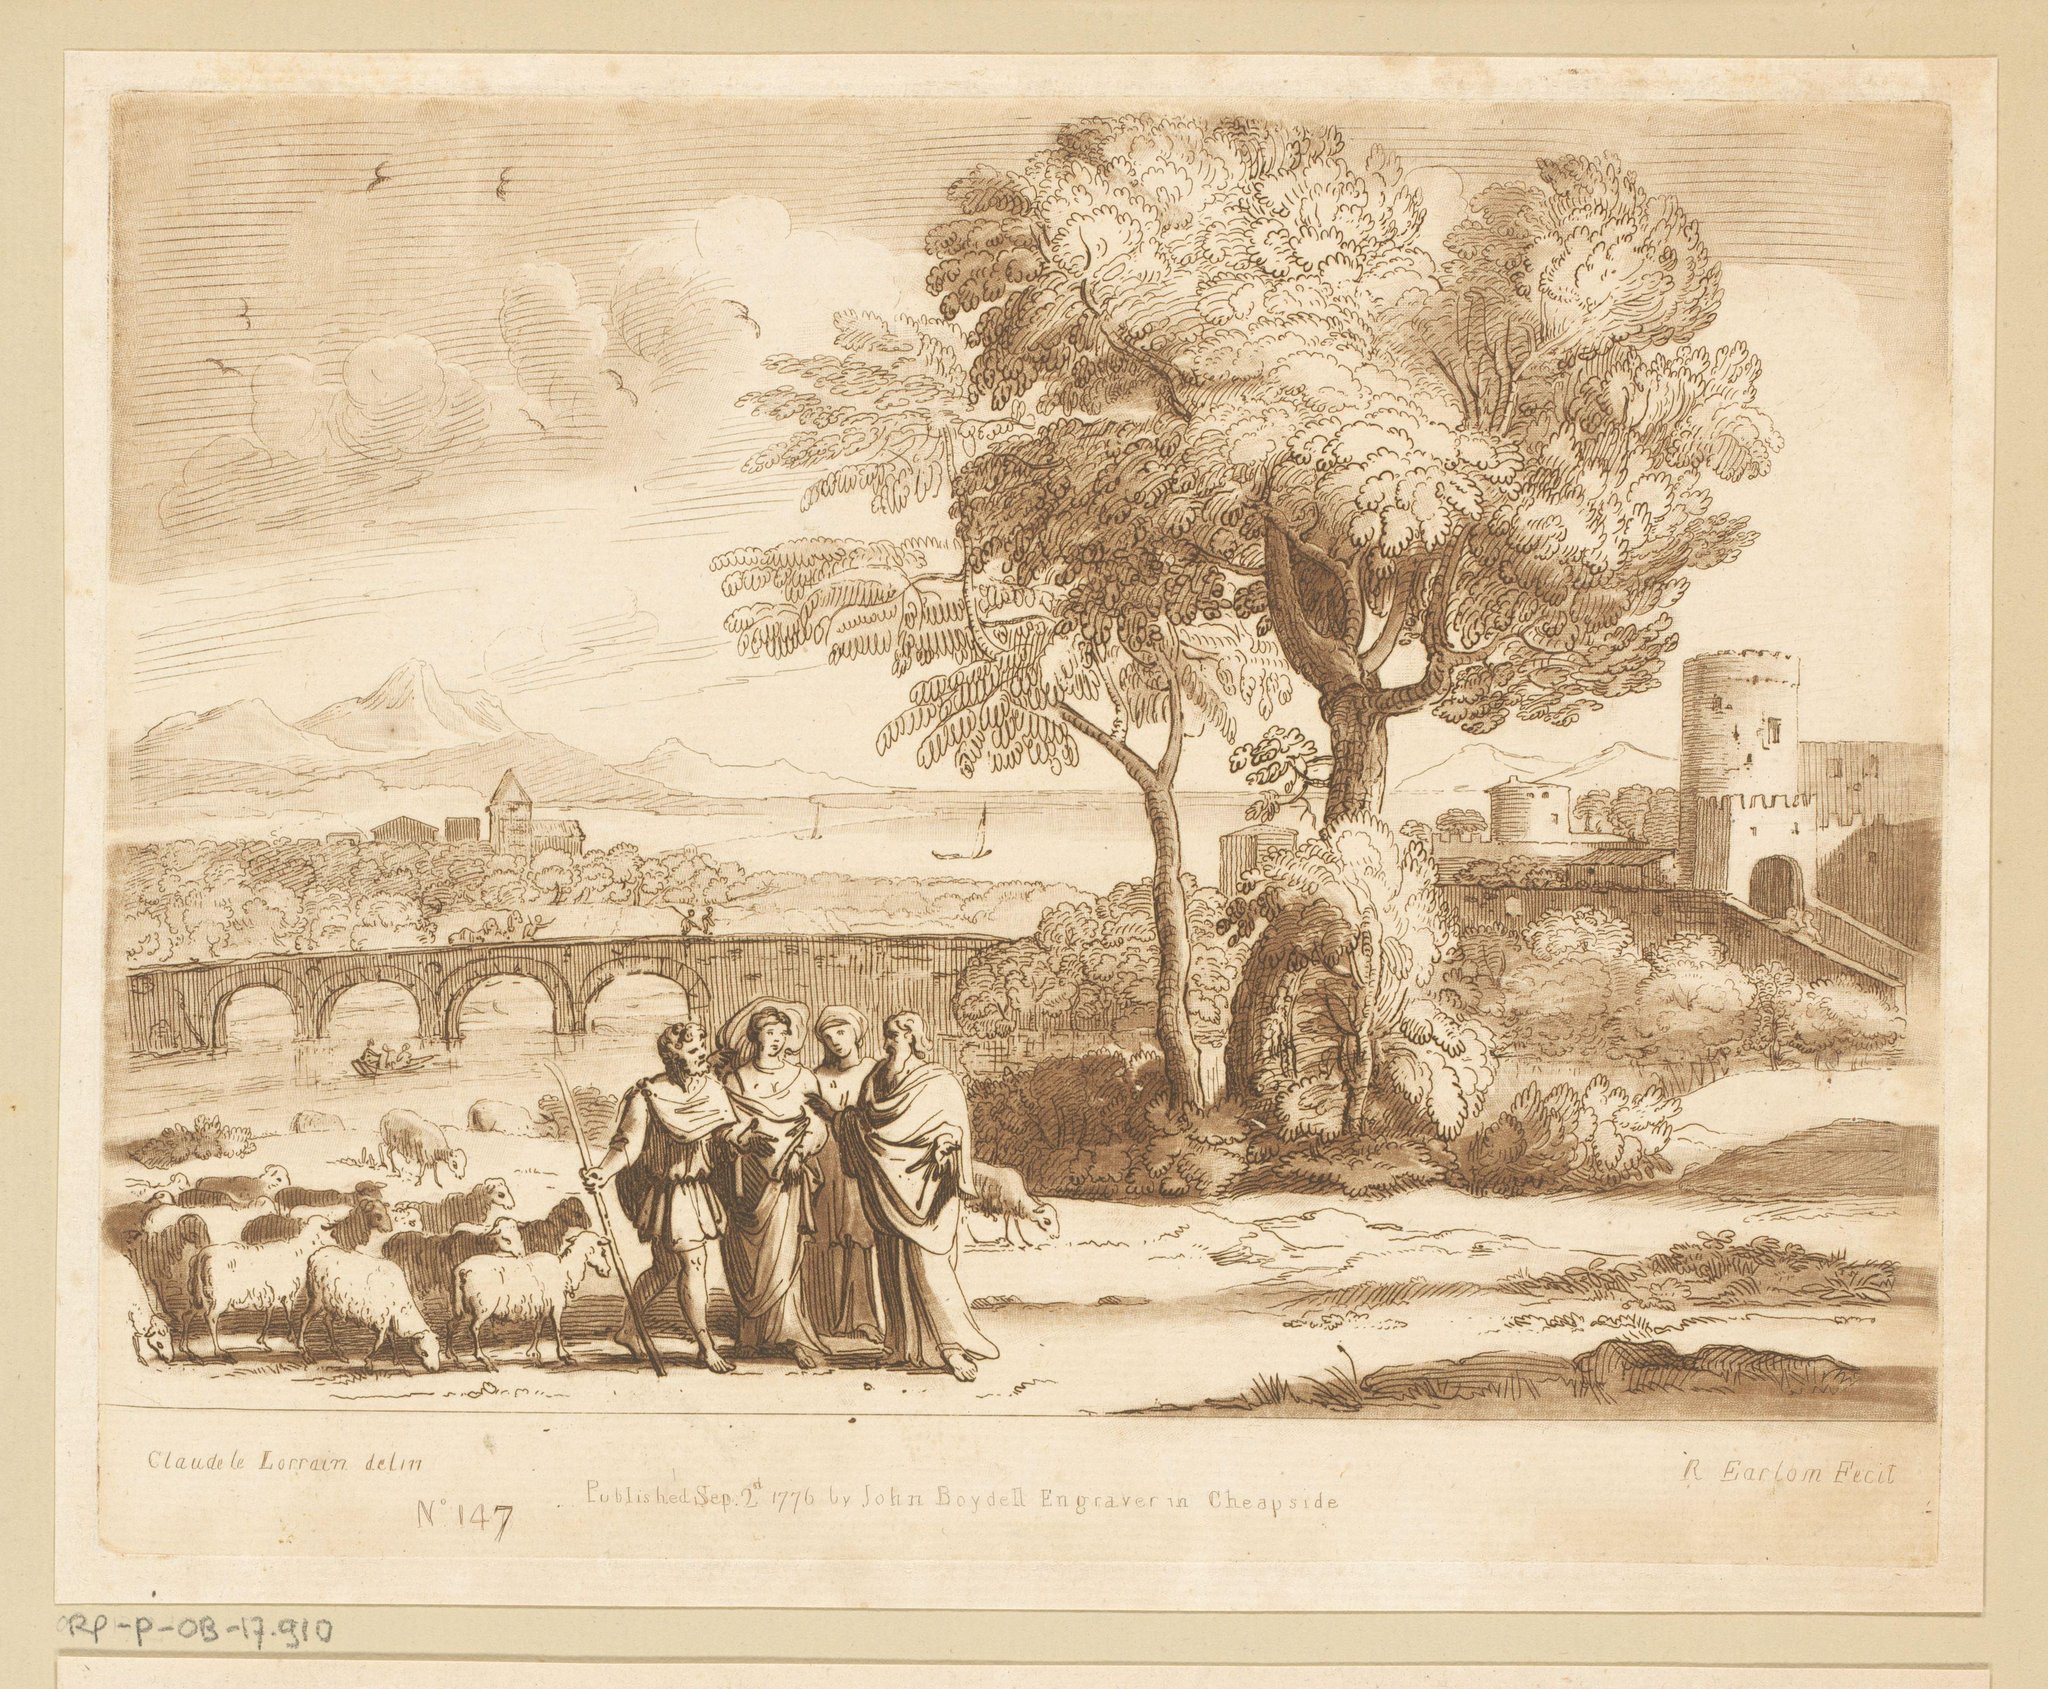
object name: print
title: Landschap met Jacob, Laban, Lea en Rachel bij een kudde schapen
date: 1776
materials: paper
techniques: etching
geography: london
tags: river - hh - ideal landscapes, city-view, and landscape with man-made constructions - ii - ideal landscapes, jacob asks laban's permission to marry rachel, landscape with bridge, viaduct or aqueduct - ii - ideal landscapes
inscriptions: date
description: Vanaf 1774 publiceerde John Boydell tweehonderd prenten naar het tekeningenboek Liber Veritatis van Claude Lorrain, in het bezit van de hertogen van Cavendish. Deze prenten werden vanaf 1777 in twee volumes gebundeld uitgegeven.